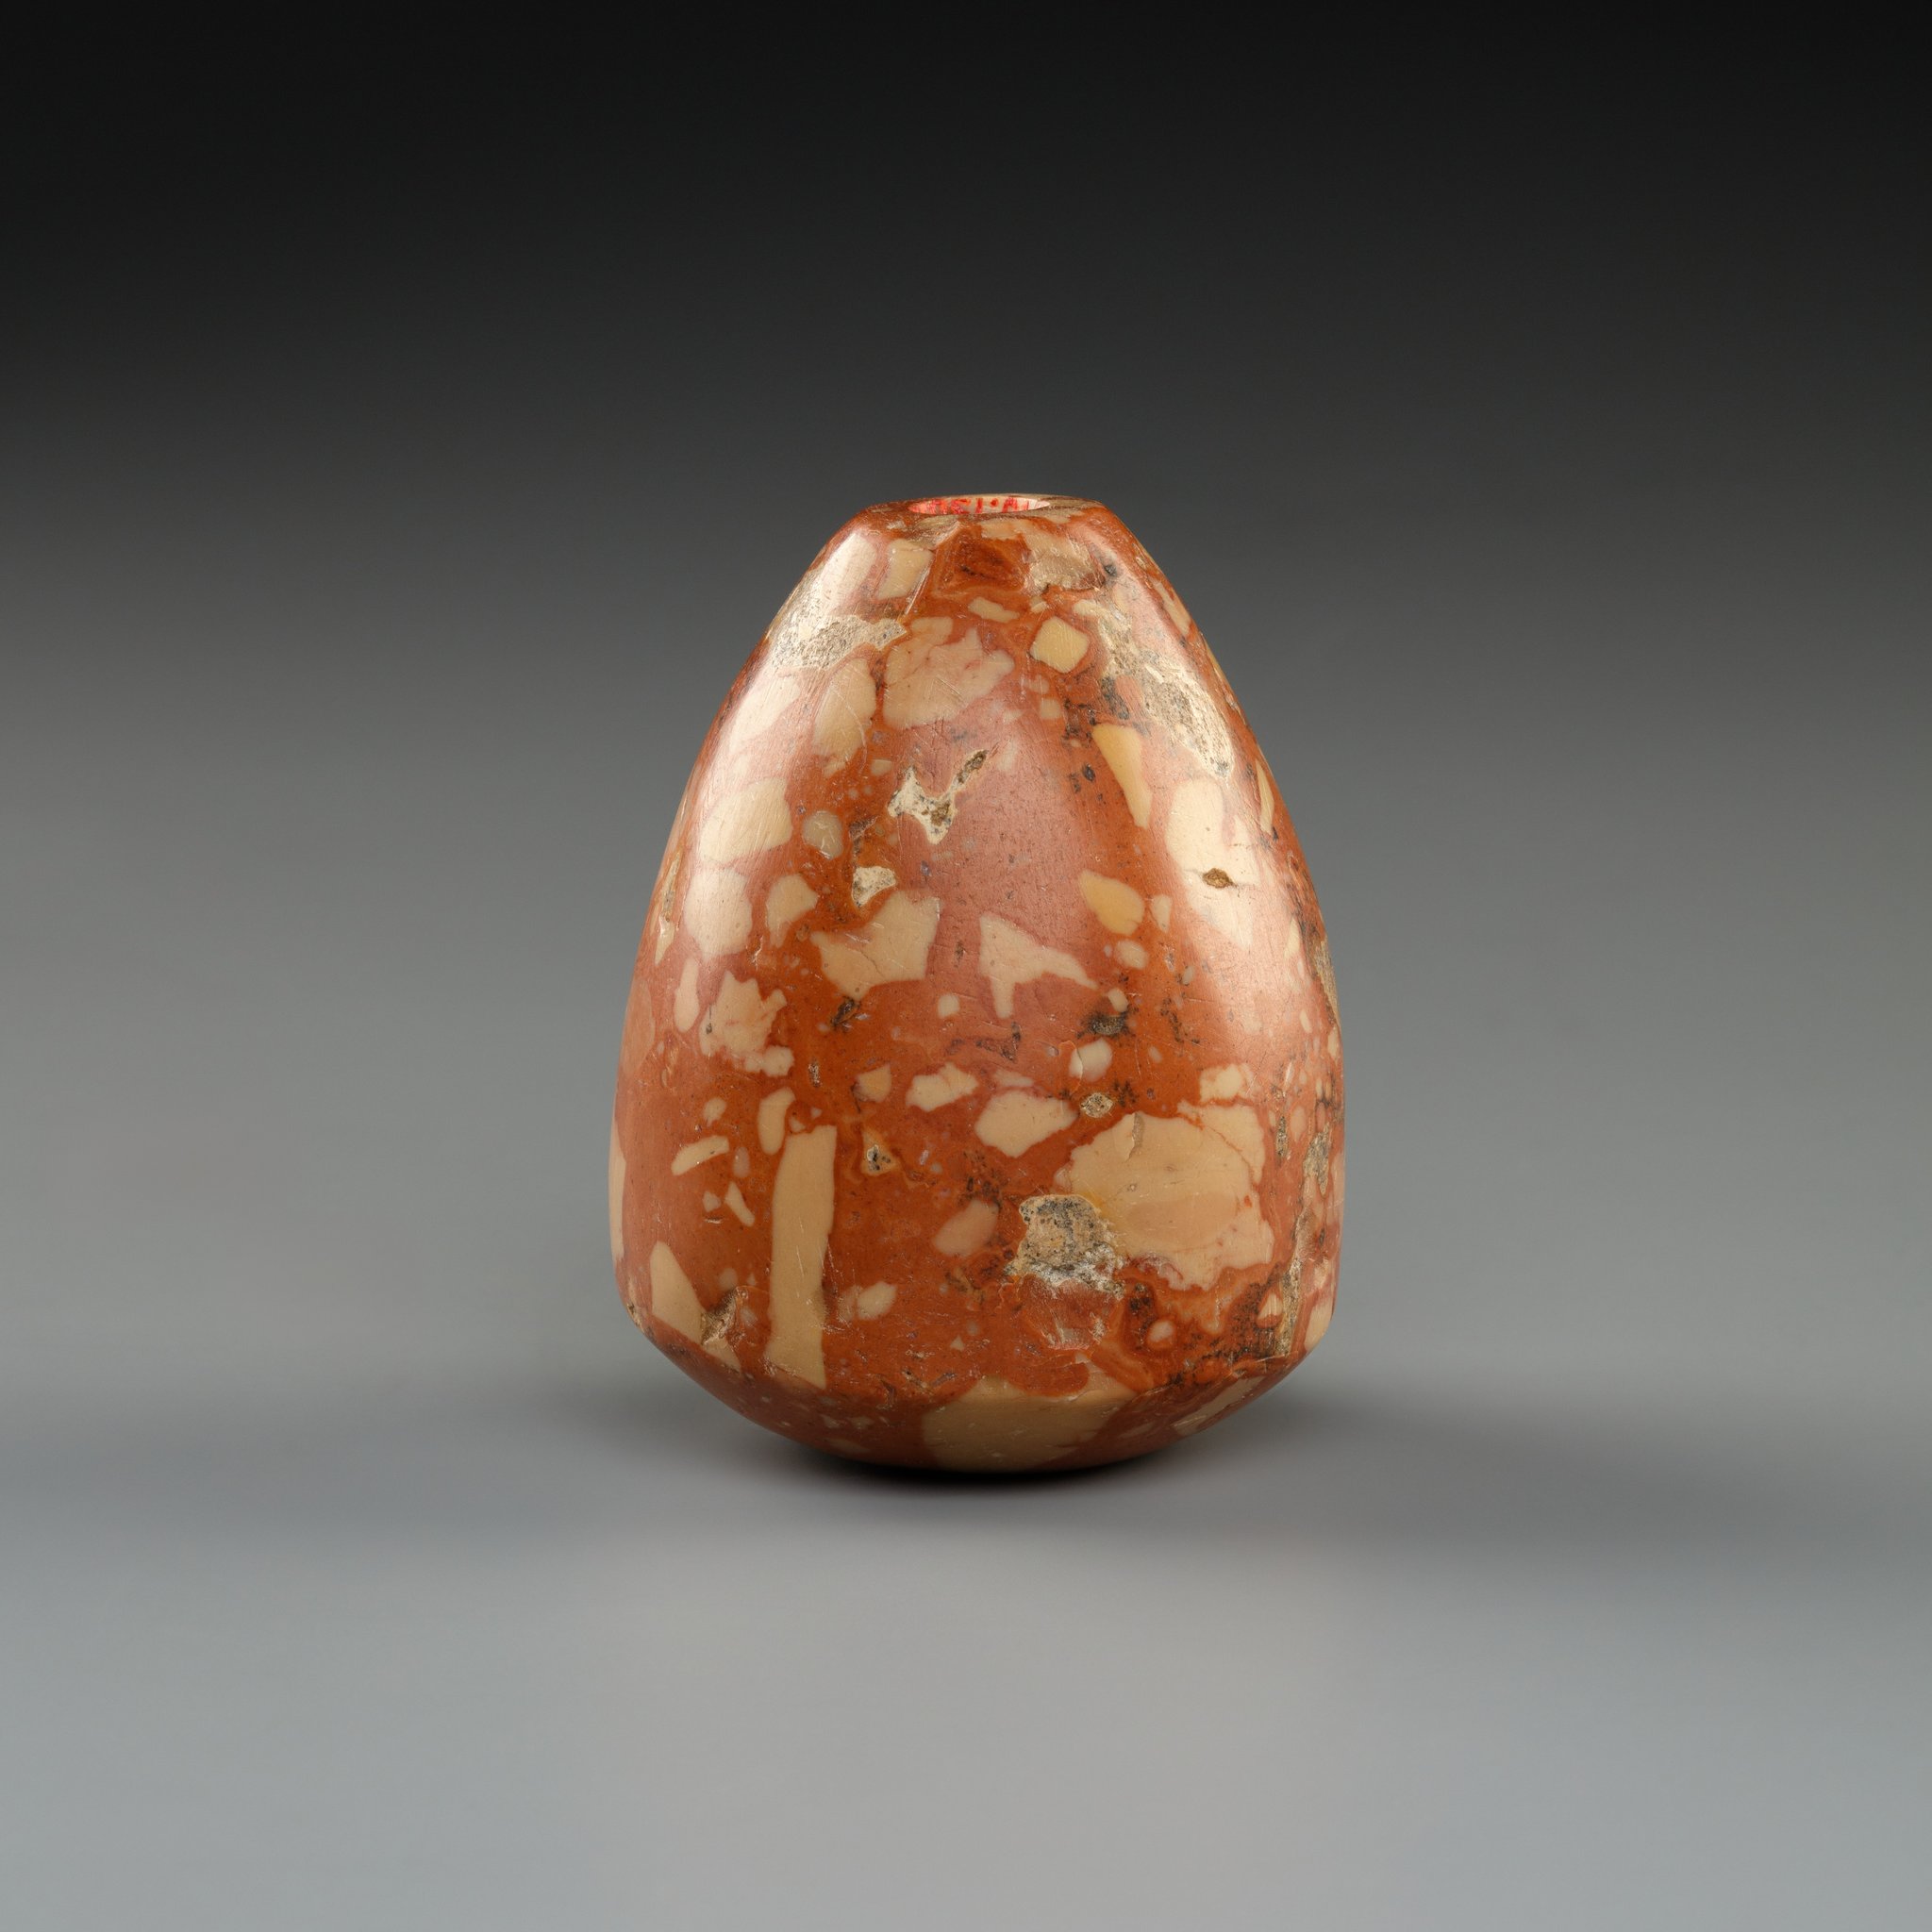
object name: mace head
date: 3850-2960 BCE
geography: egypt